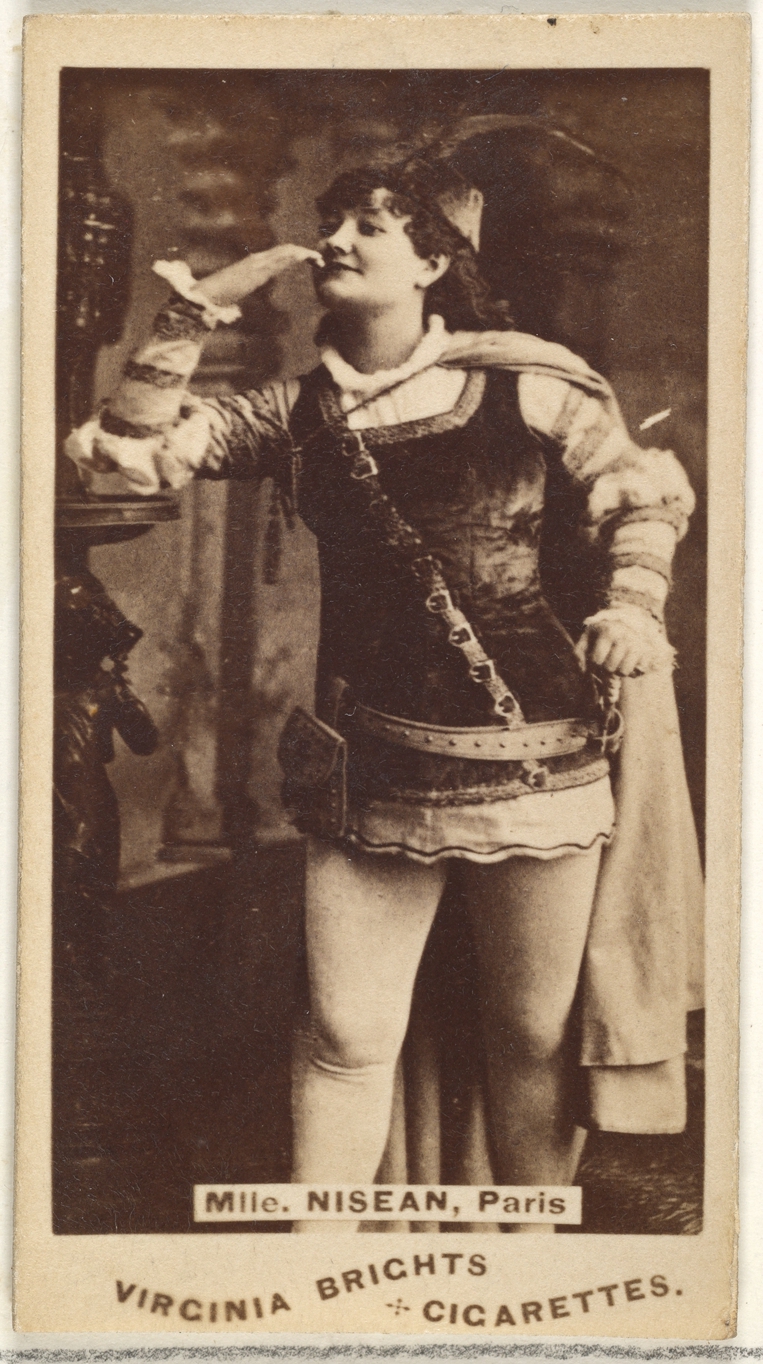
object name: photograph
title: Mlle. Nisean, Paris, from the Actors and Actresses series (N45, Type 1) for Virginia Brights Cigarettes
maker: allen & ginter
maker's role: publisher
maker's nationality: american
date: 1888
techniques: albumen silver print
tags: portraits,women,actresses